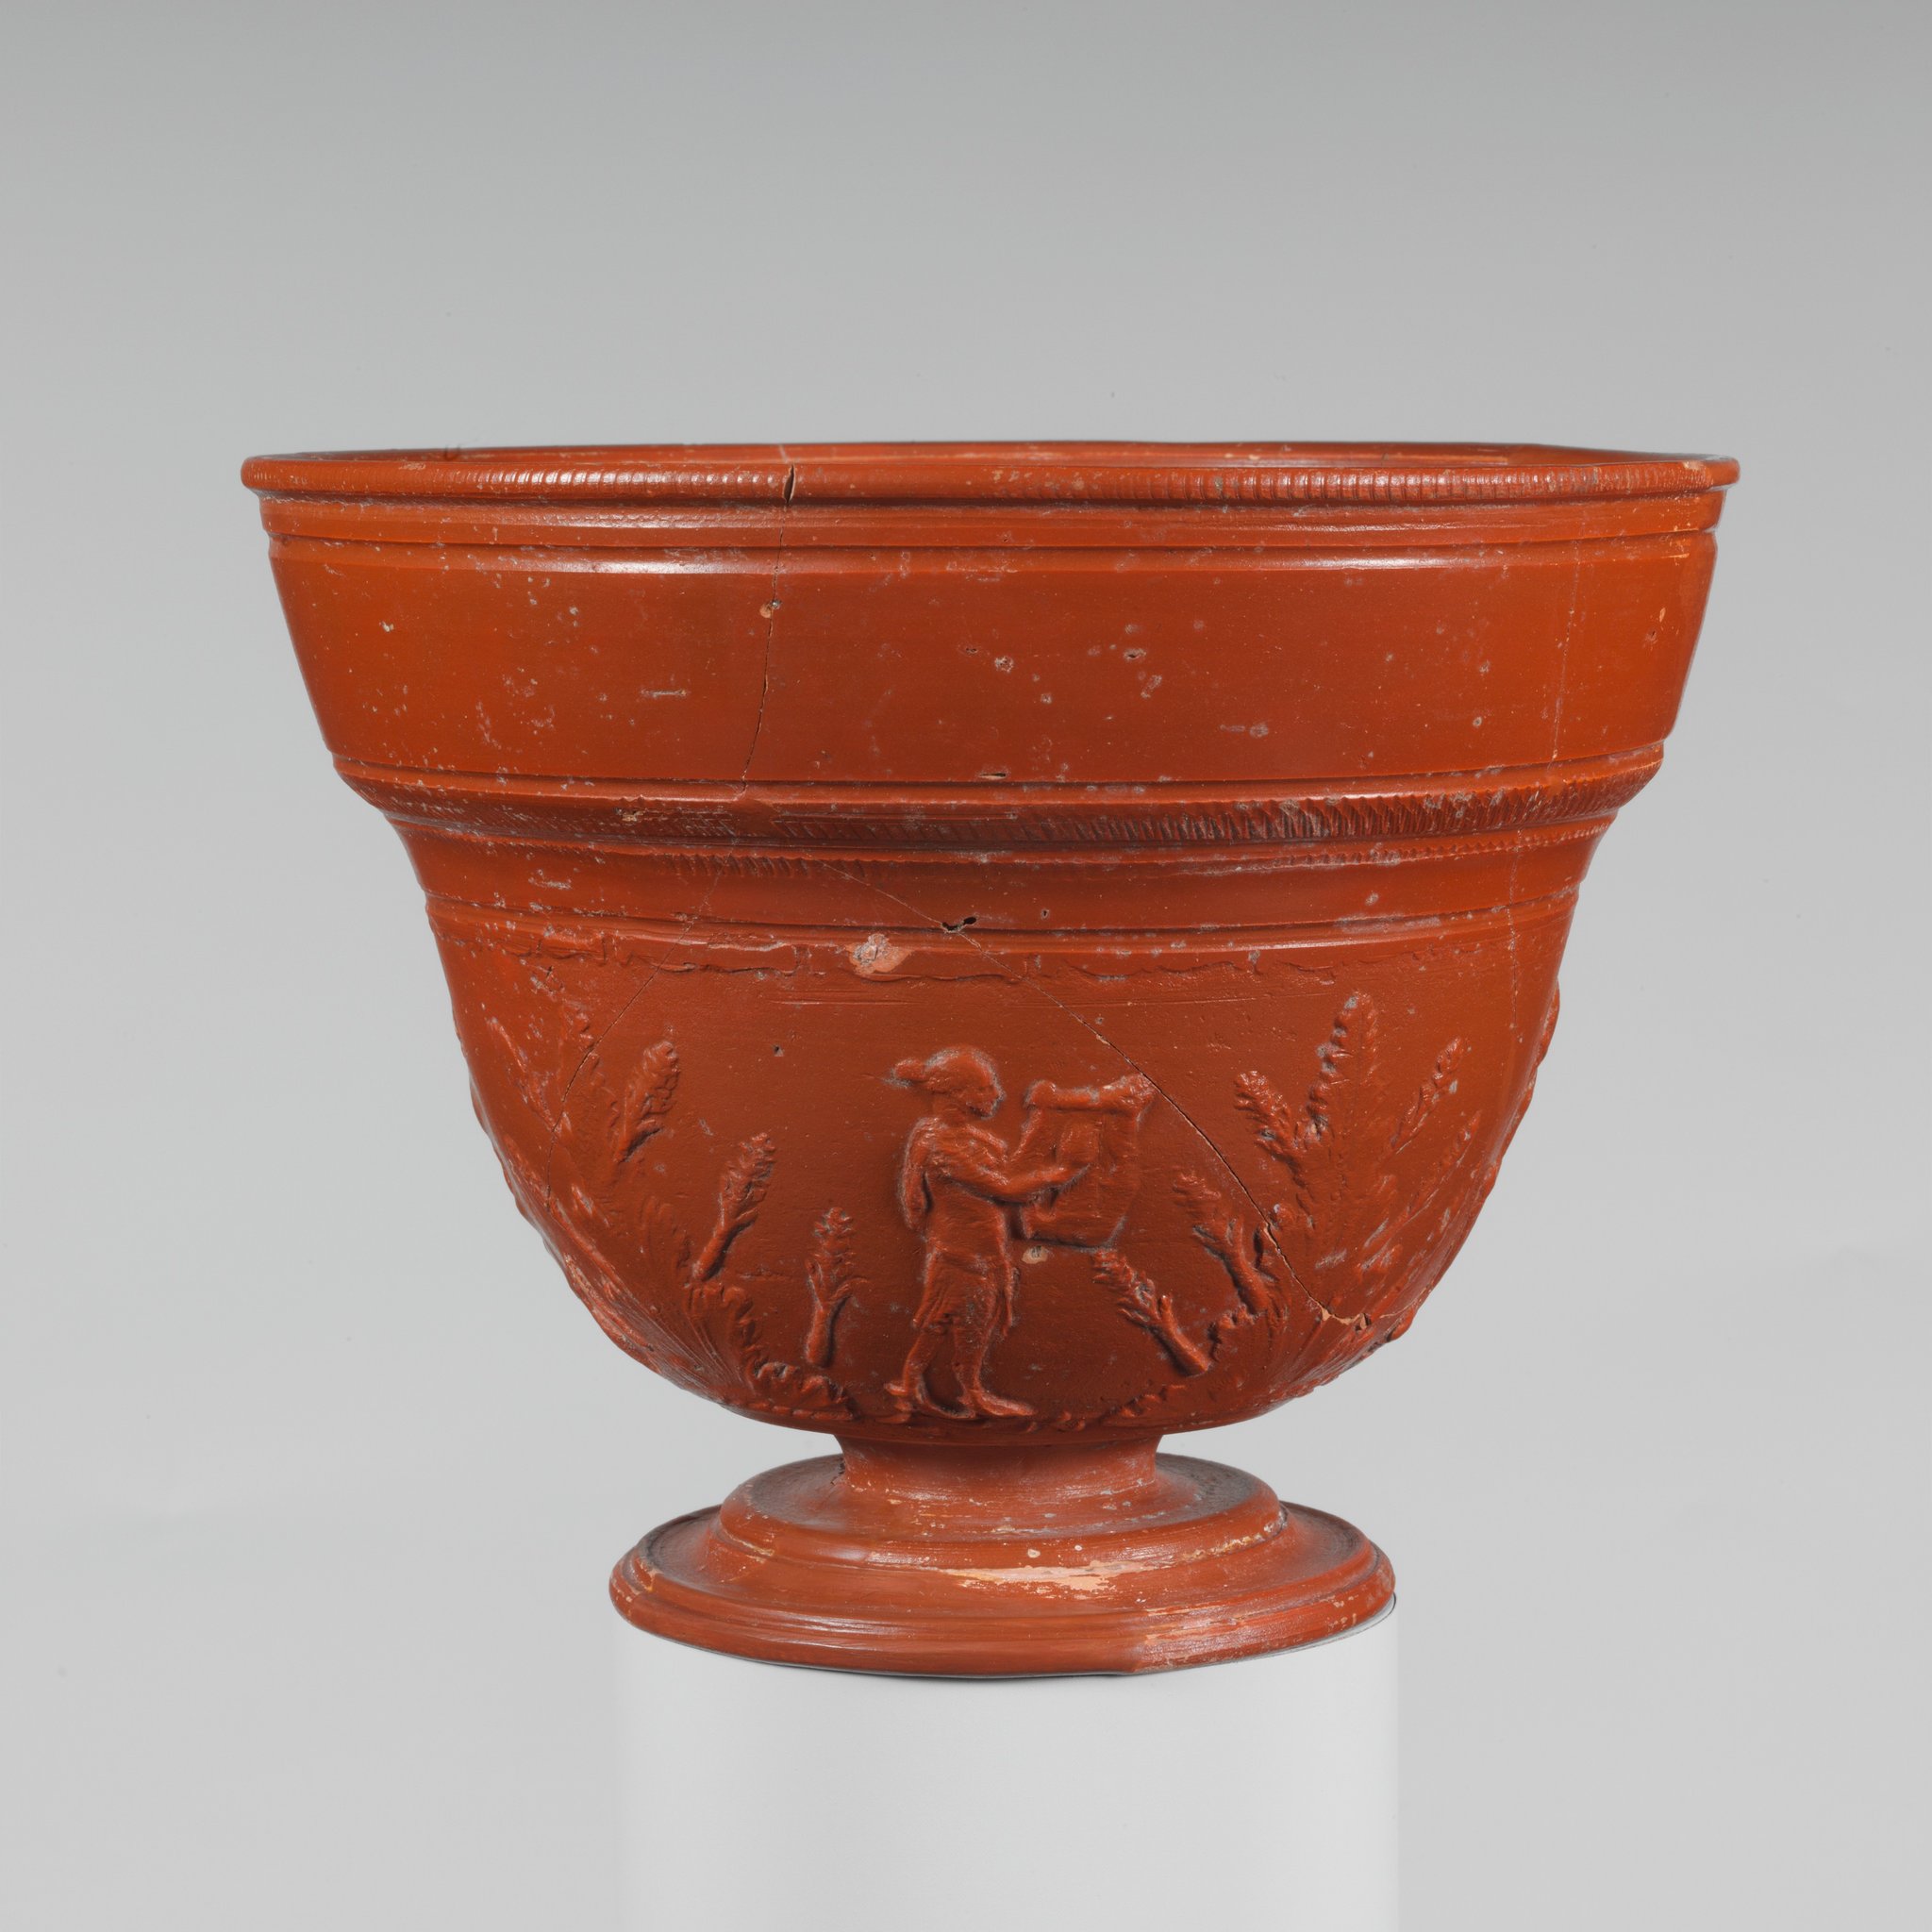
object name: bowl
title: Terracotta bowl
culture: roman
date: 1-10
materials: terracotta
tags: apollo,lyres